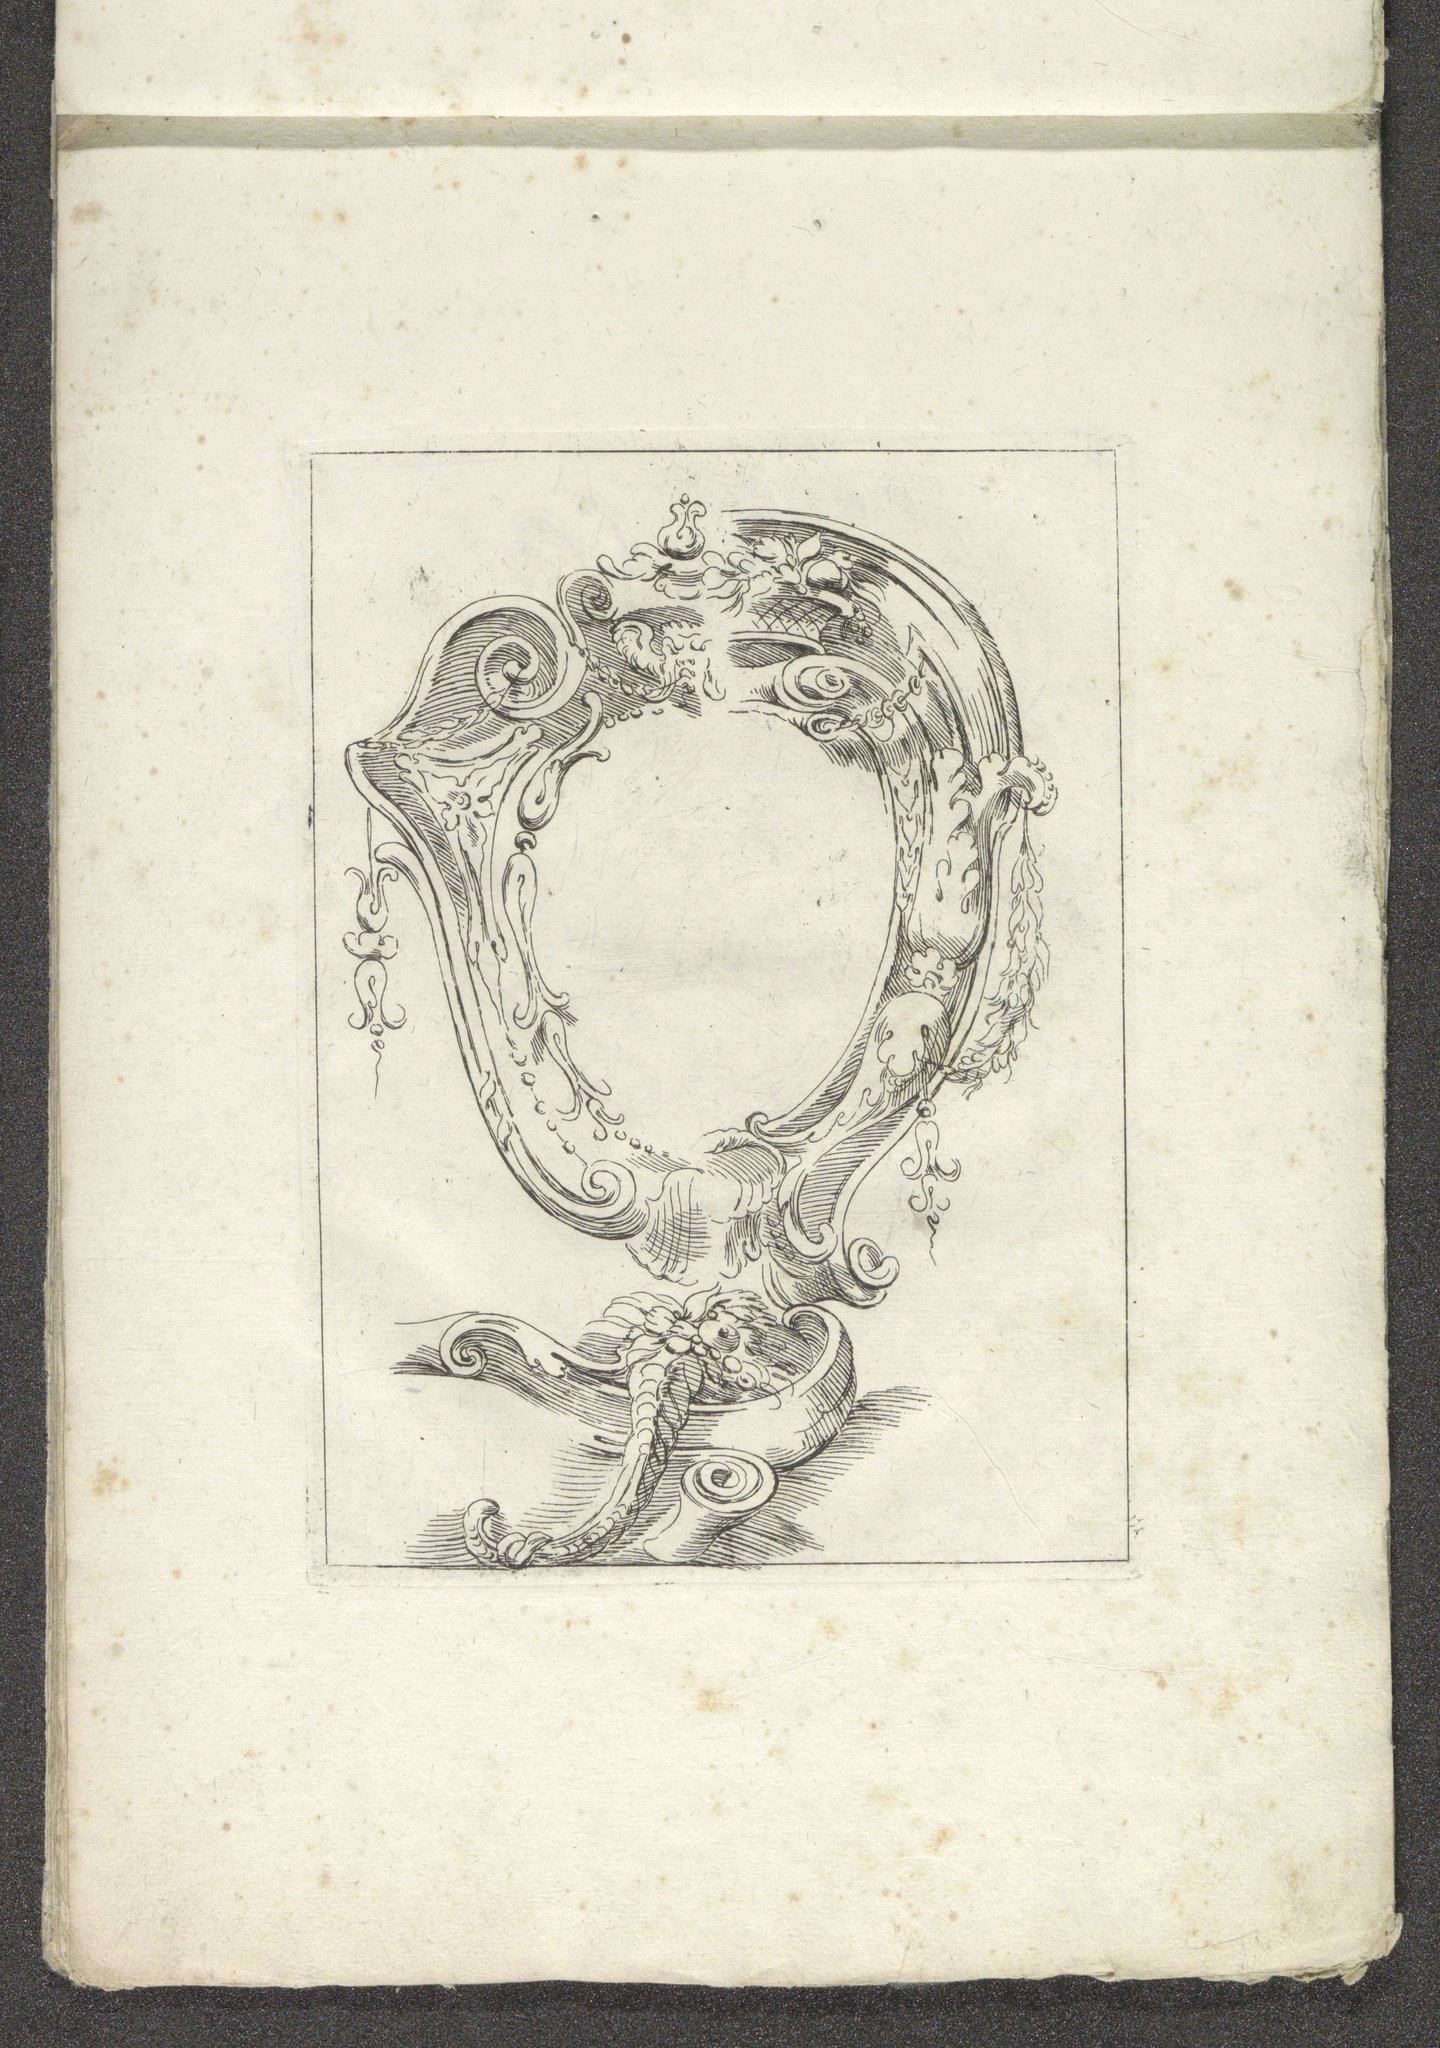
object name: ornament print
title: Cartouche en detail ornament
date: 1644-1718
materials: paper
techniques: etching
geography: italy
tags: ornaments ~ art, ornament ~ cartouche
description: Boven een cartouche met bloemen in de rand. Onder een detail van een ornament met een hoorn met vruchten. De prent maakt deel uit van een album.